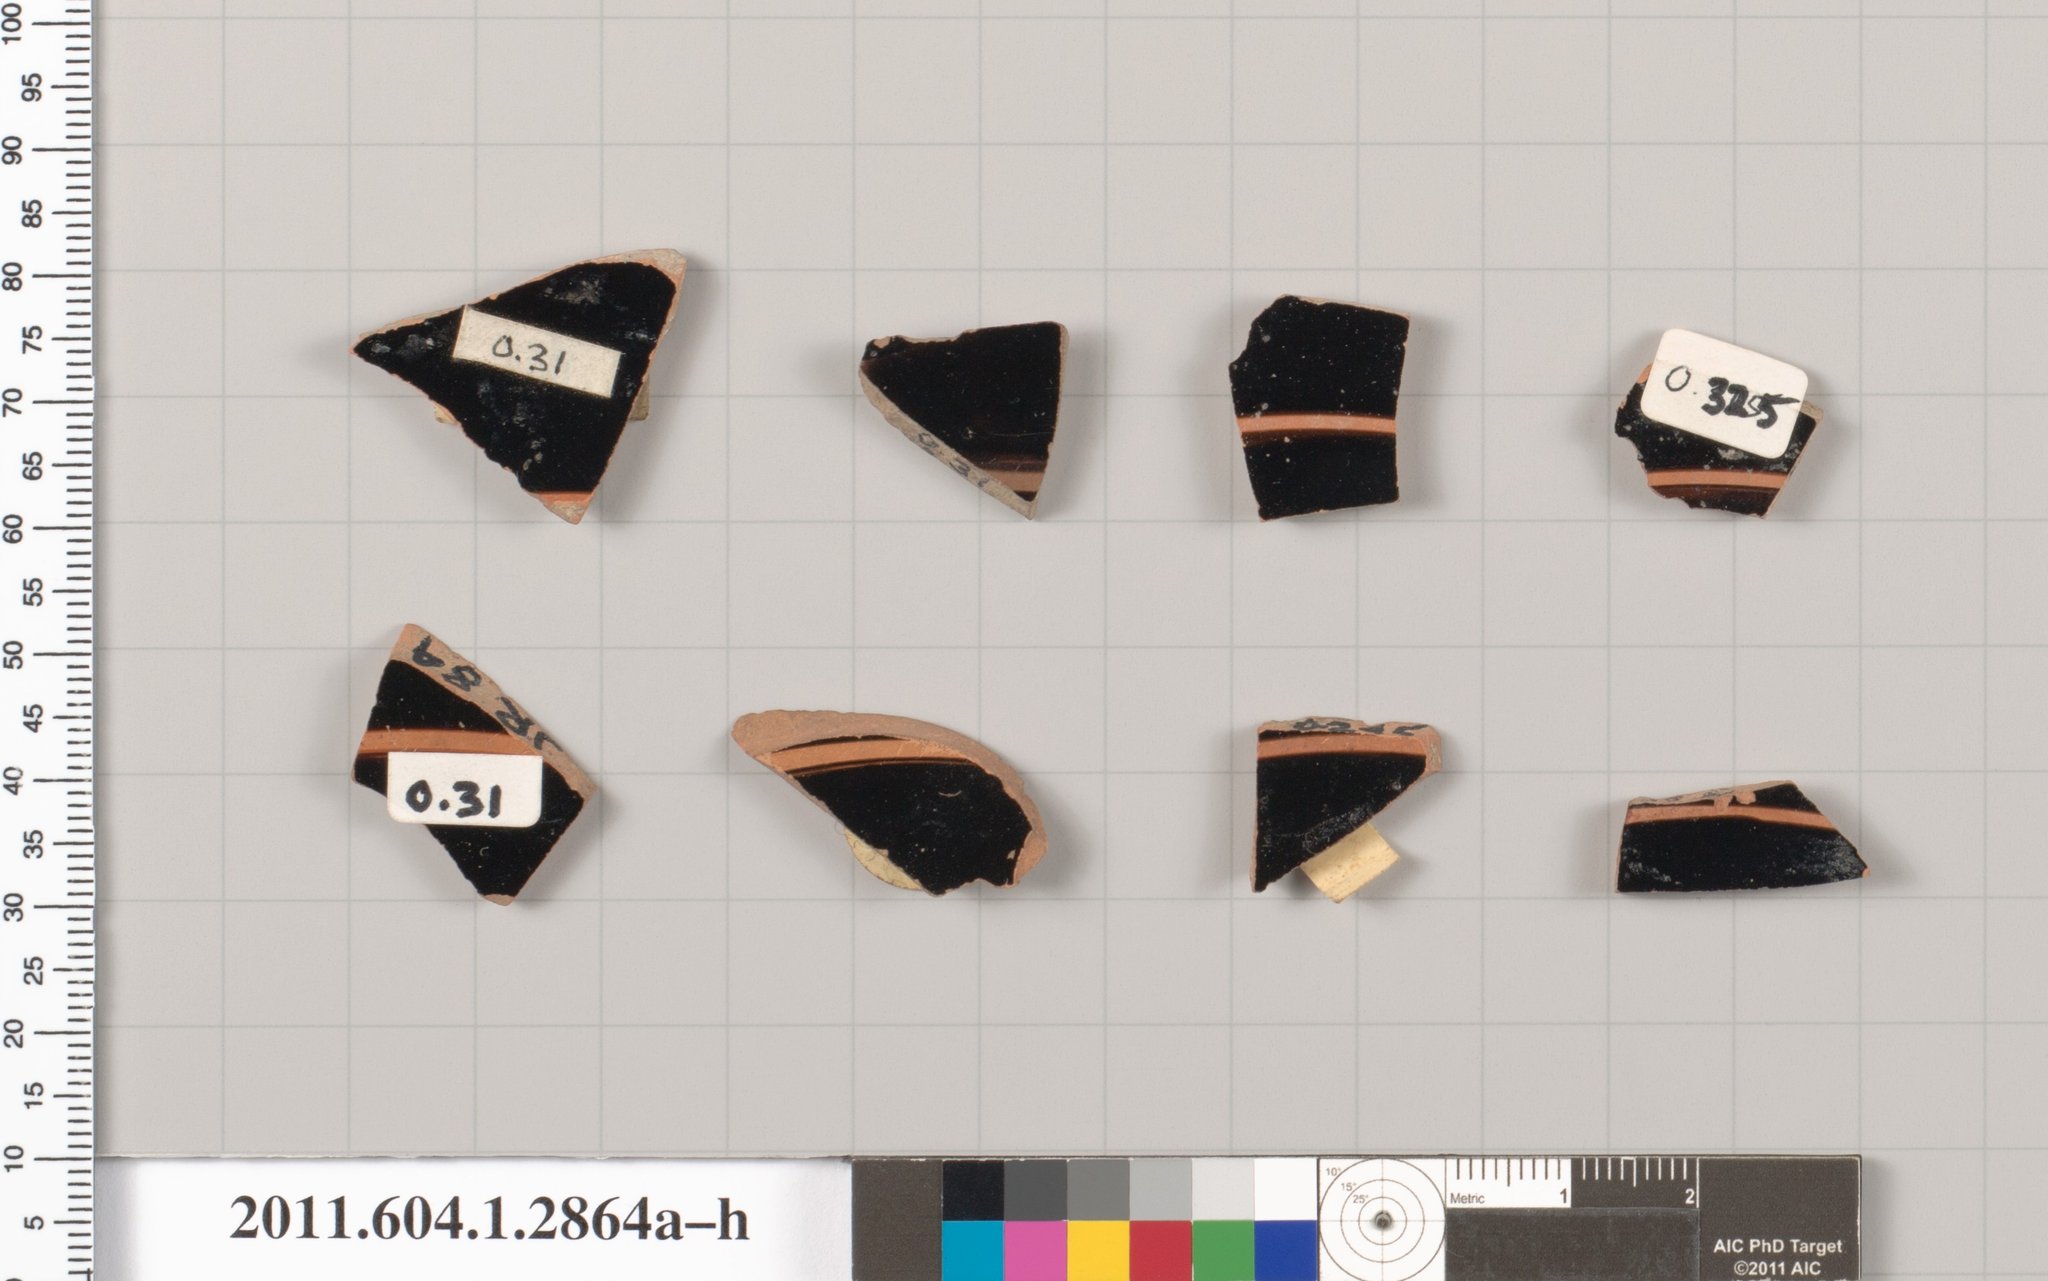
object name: kylix fragment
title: Terracotta fragments of kylikes (drinking cups)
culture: greek, attic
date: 600-401 BCE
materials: terracotta